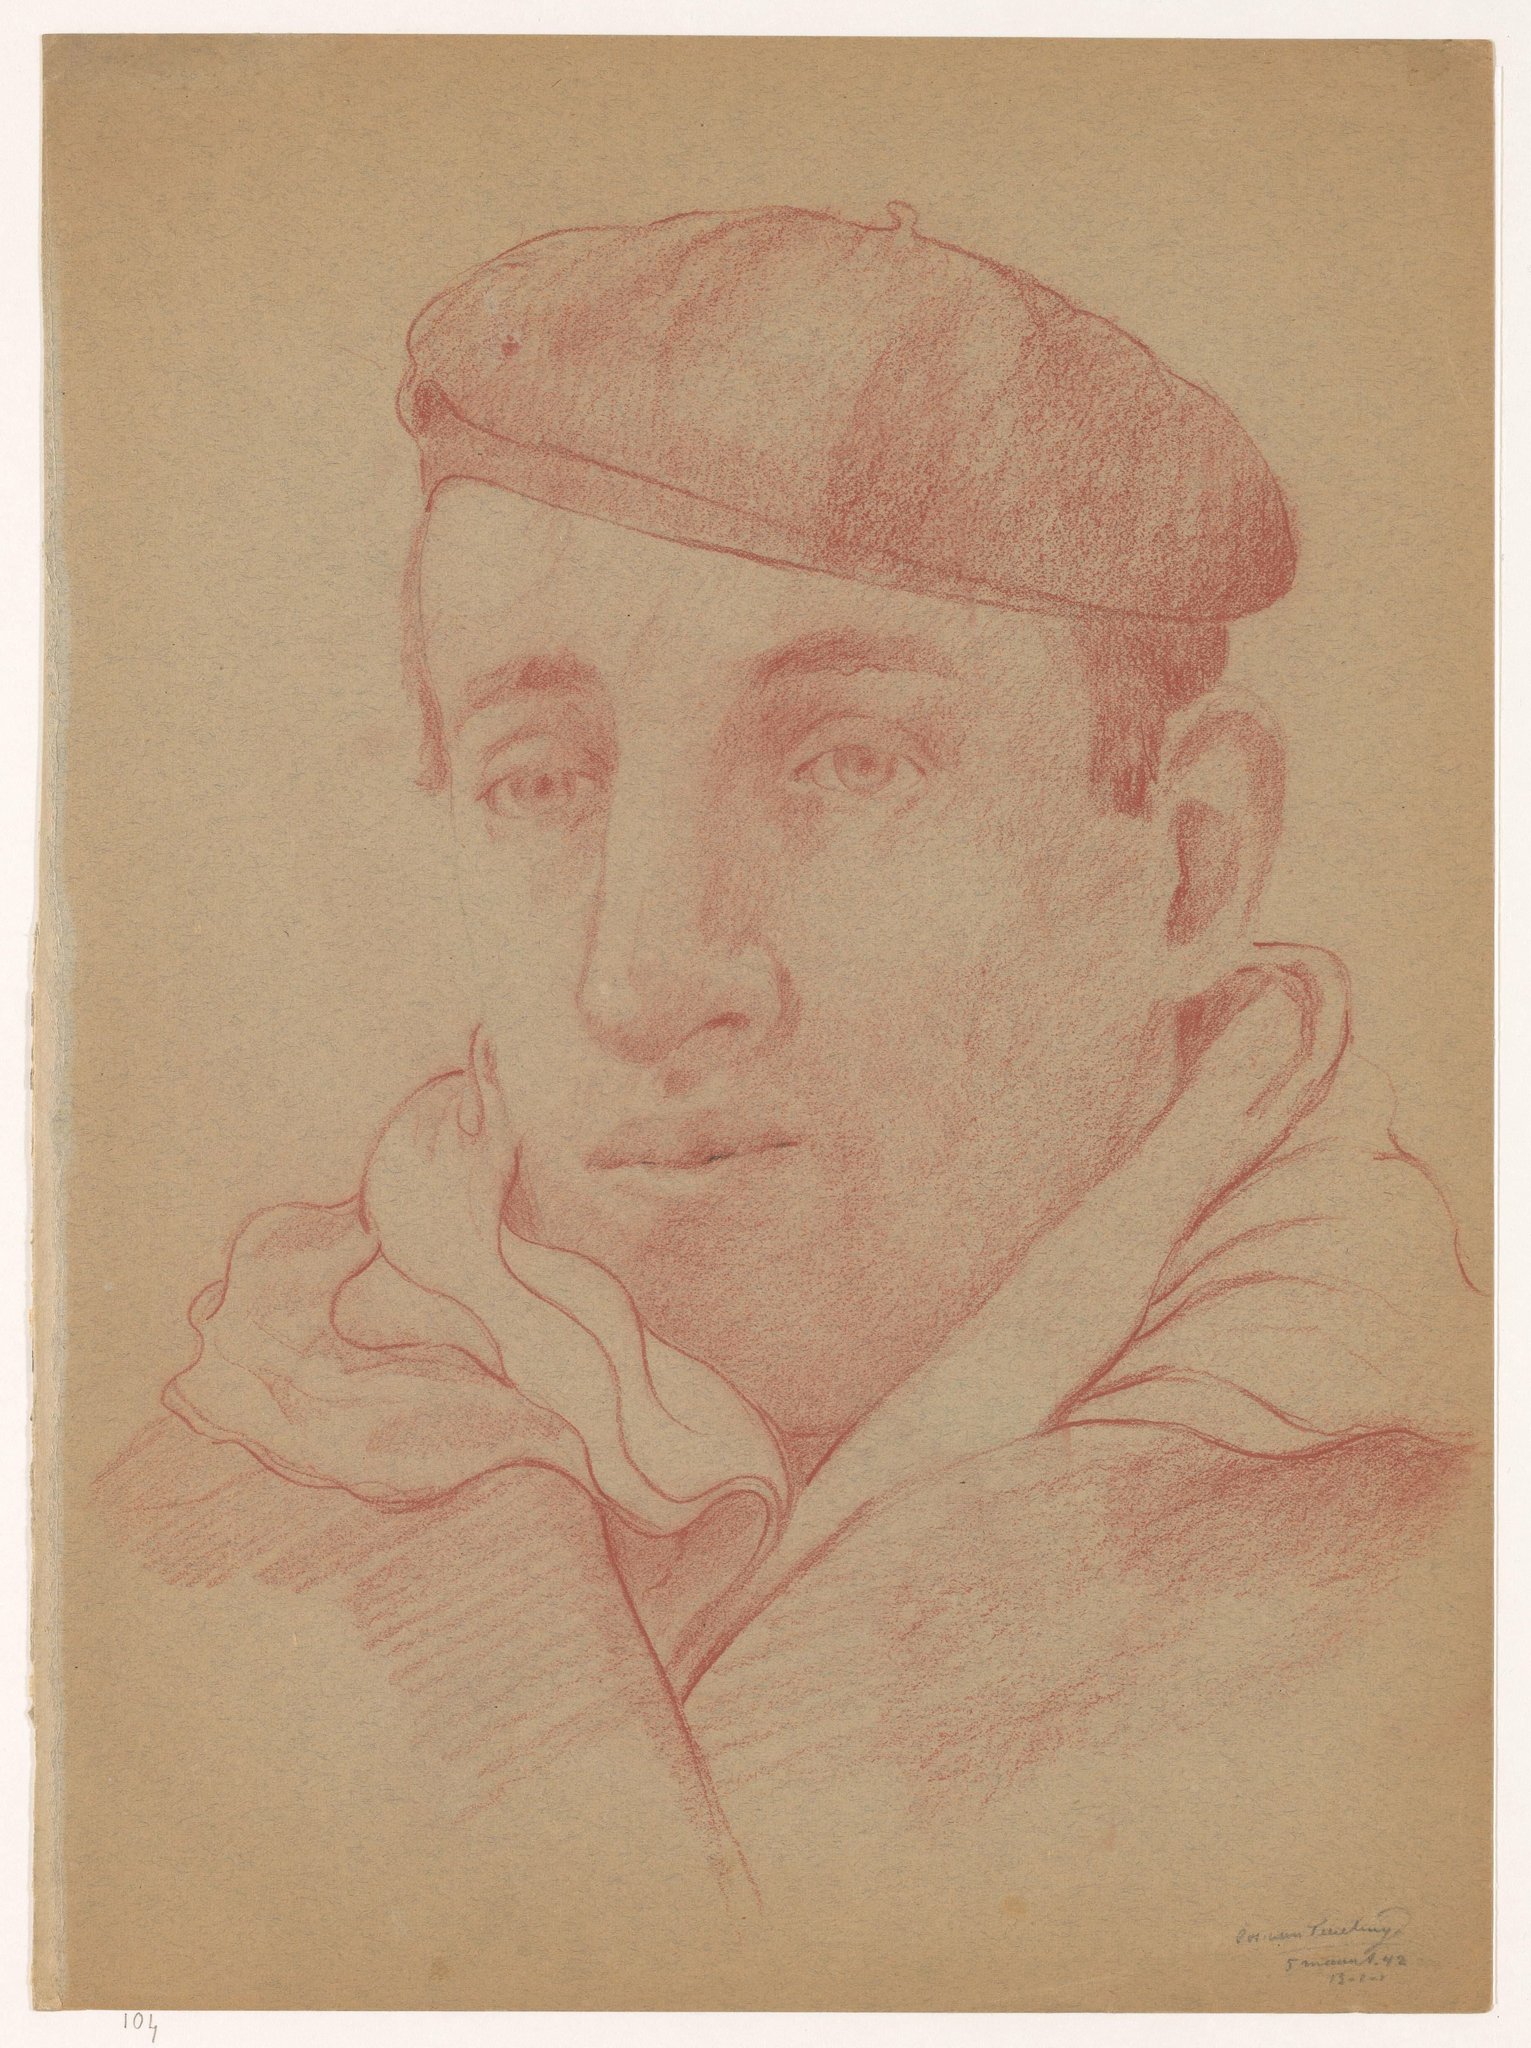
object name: drawing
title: Zelfportret met alpinopet: B-1-1, 5 maart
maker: cor van teeseling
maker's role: draughtsman, sculptor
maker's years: 1915-1942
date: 1942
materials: chalk, paper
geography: weteringschans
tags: amsterdam, draughtsman, sculptor, cor van teeseling, historical persons, prisoner in cell or locked place, portrait, self-portrait of draughtsman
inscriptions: signature and date: ‘Cor van Teeseling / 26 Jan. 1942’, title: ‘B-1-1’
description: Zelfportret van Cor van Teeseling met alpinopet: B-1-1, 5 maart. Getekend zelfportret van Cor van Teeseling met alpinopet.